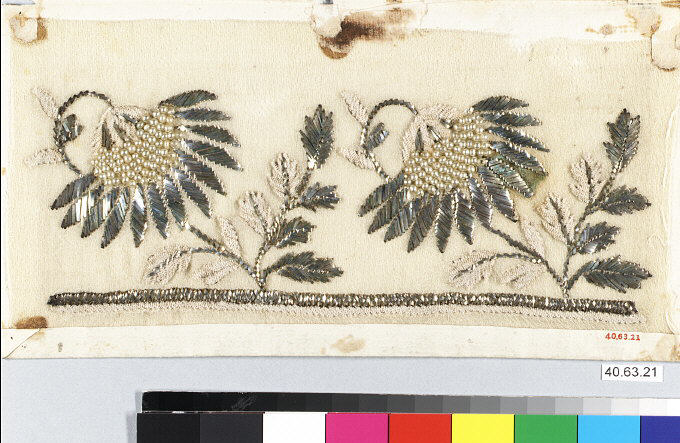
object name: border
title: Dress border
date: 1801-1833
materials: silk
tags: flowers